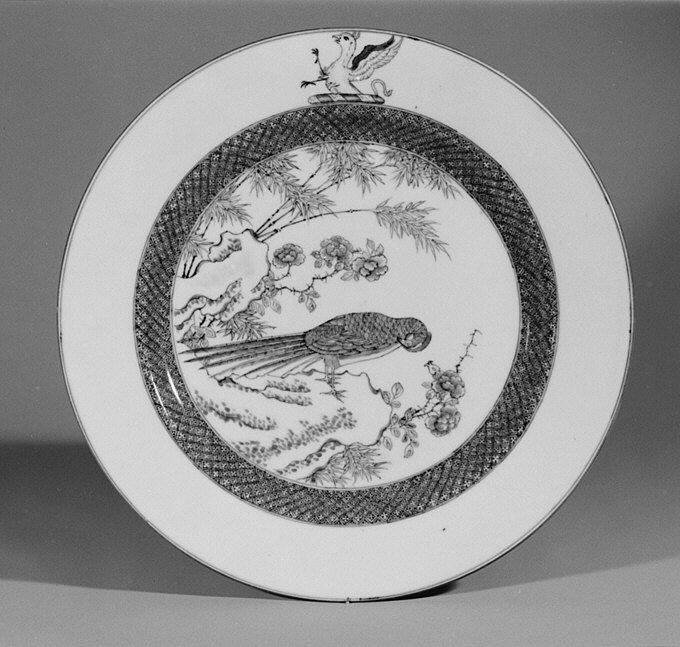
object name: plate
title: Plate (one of a pair)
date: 1731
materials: hard paste porcelain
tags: birds,flowers